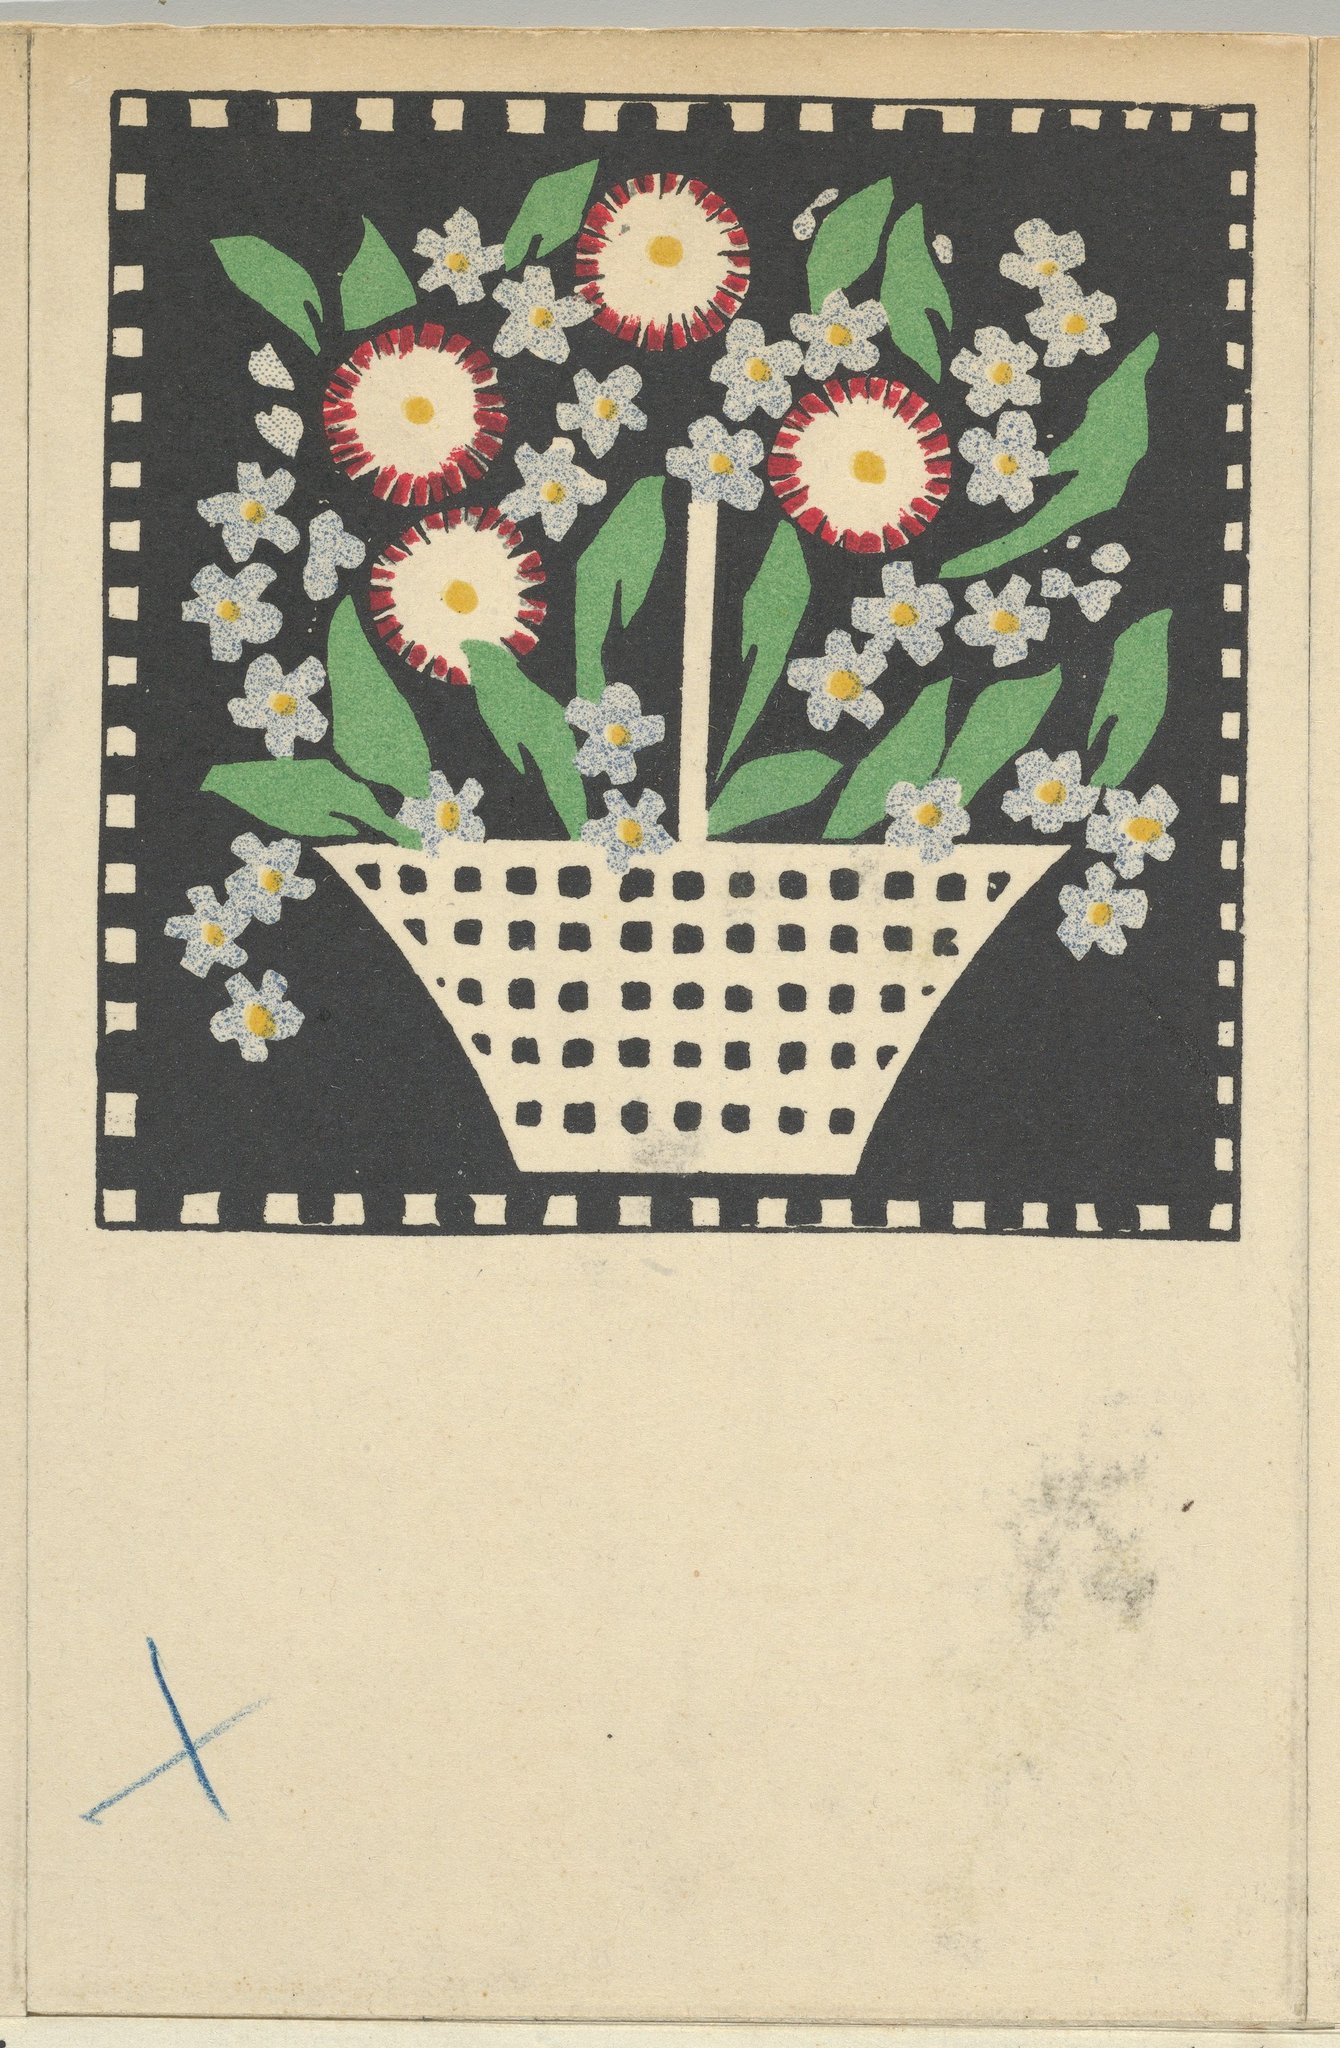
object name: print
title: Basket of Flowers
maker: leopoldine kolbe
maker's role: artist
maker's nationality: austrian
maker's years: 1870-1912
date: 1907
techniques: lithograph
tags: flowers